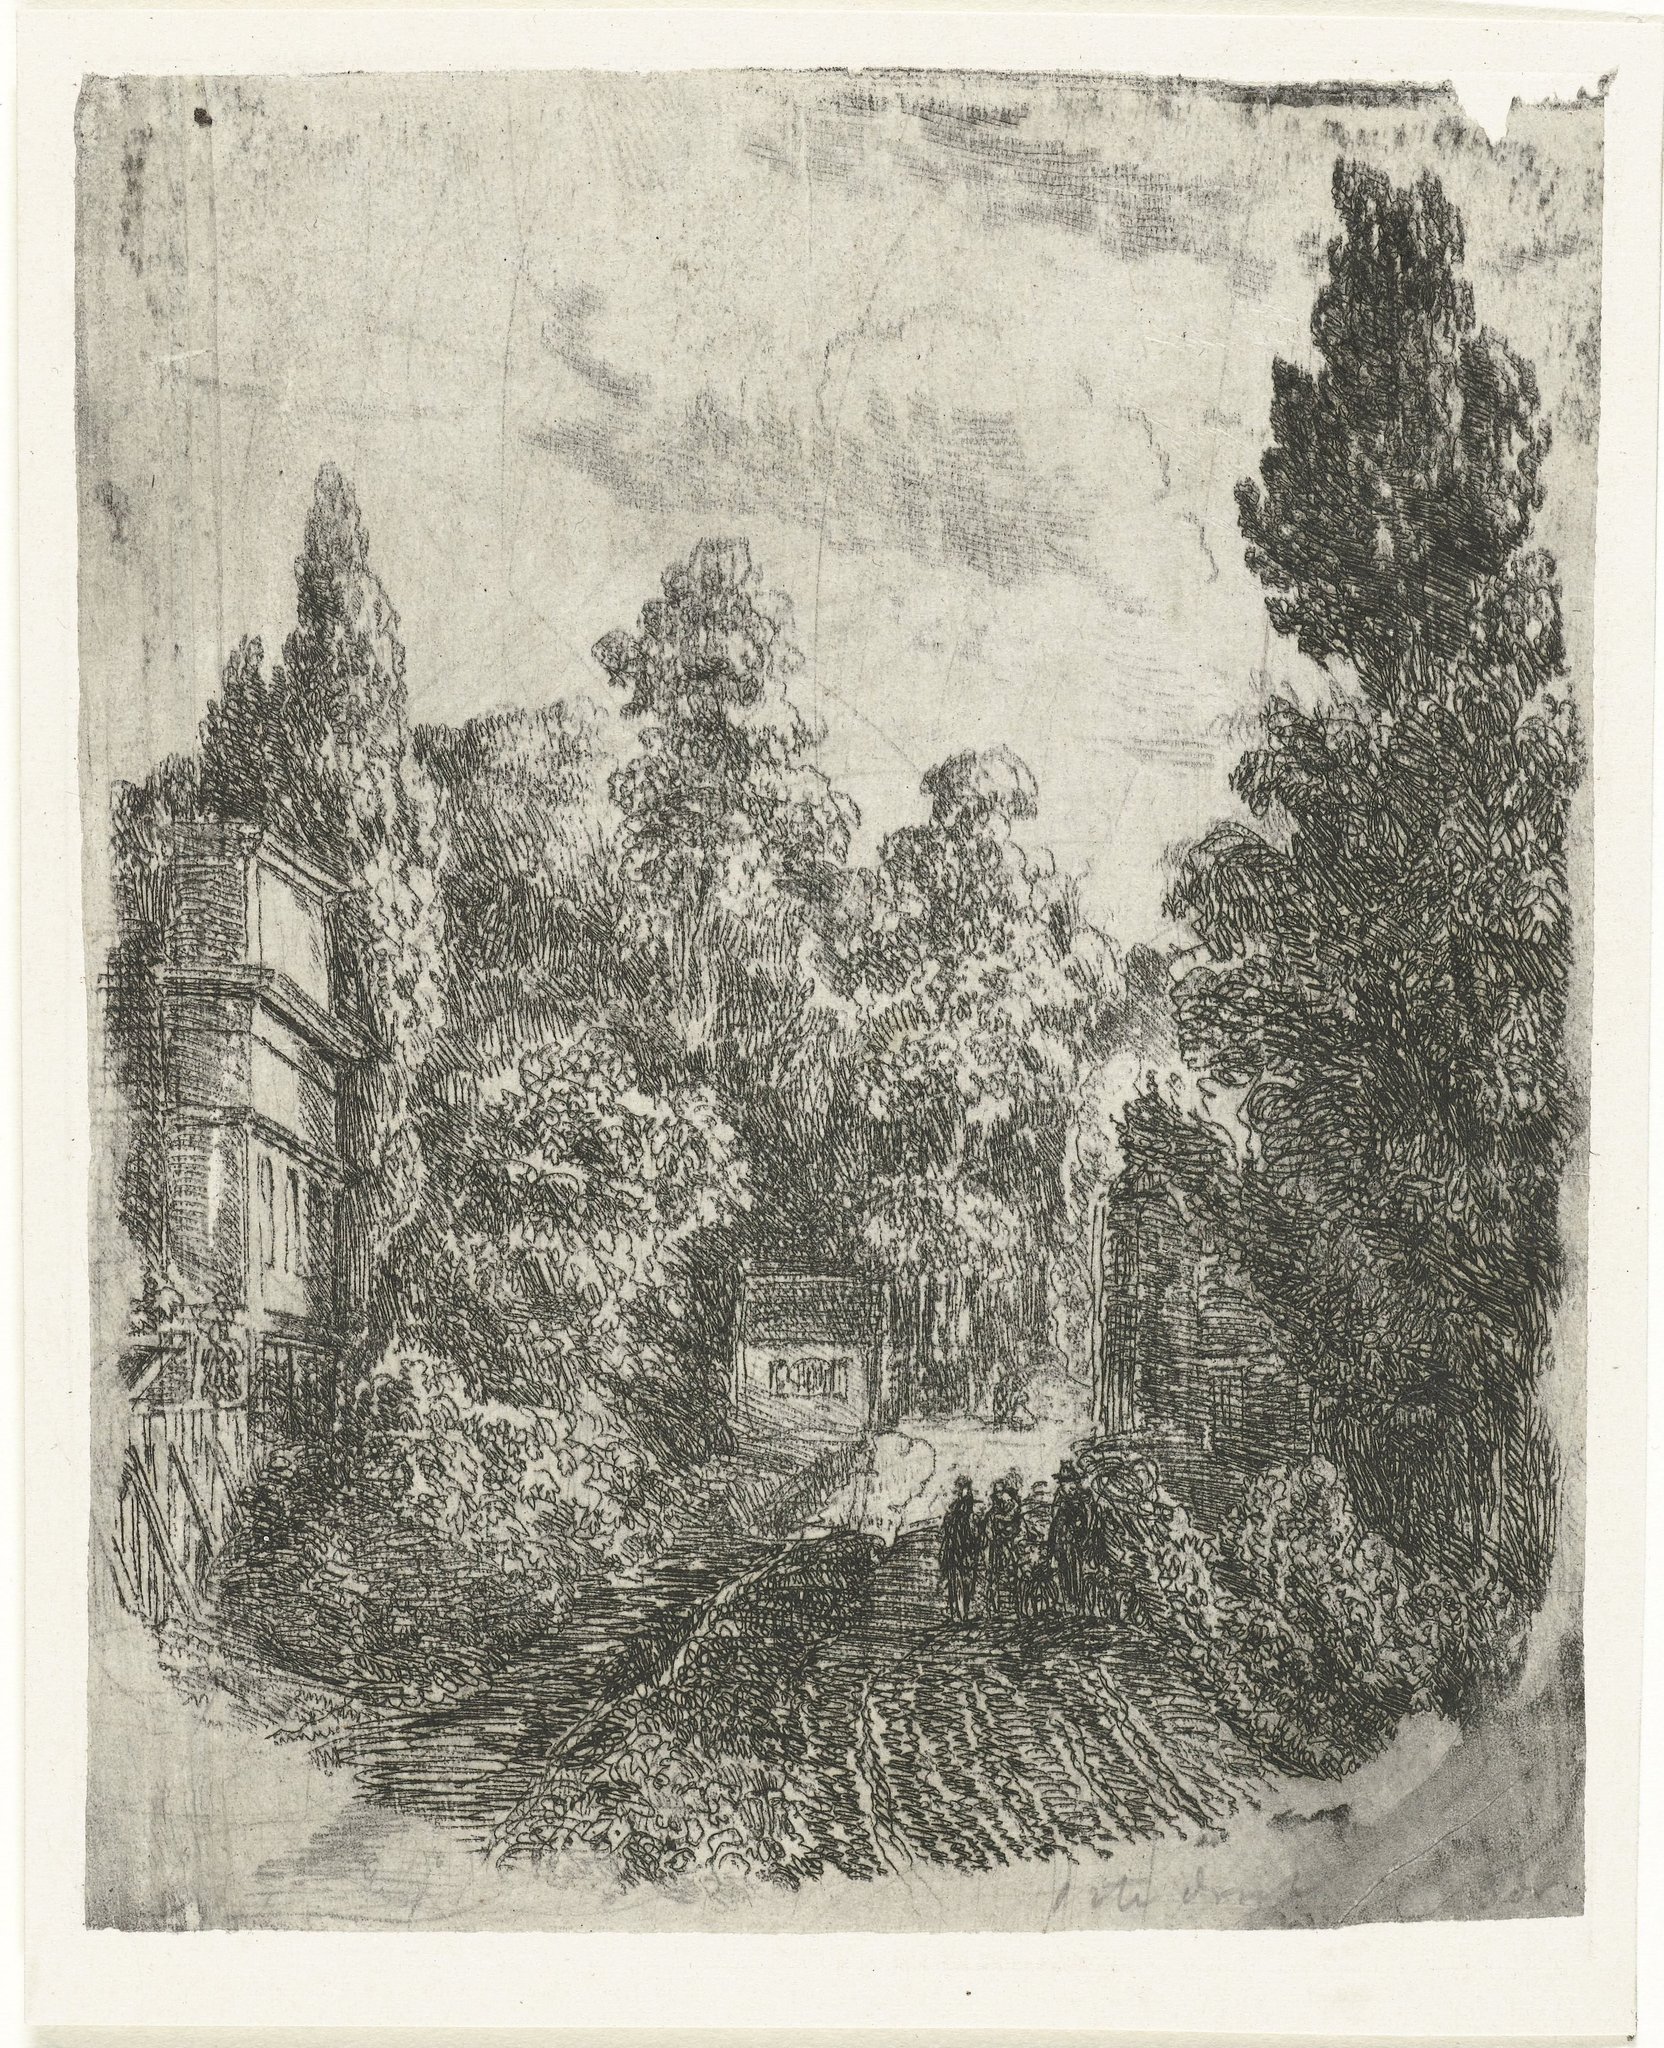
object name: print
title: Landschap met drie wandelaars op een weg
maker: johannes adrianus van der drift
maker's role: print maker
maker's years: 1808-1883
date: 1823-1883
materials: paper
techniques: etching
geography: netherlands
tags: landscapes in the temperate zone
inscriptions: collector's mark: Lugt 2228